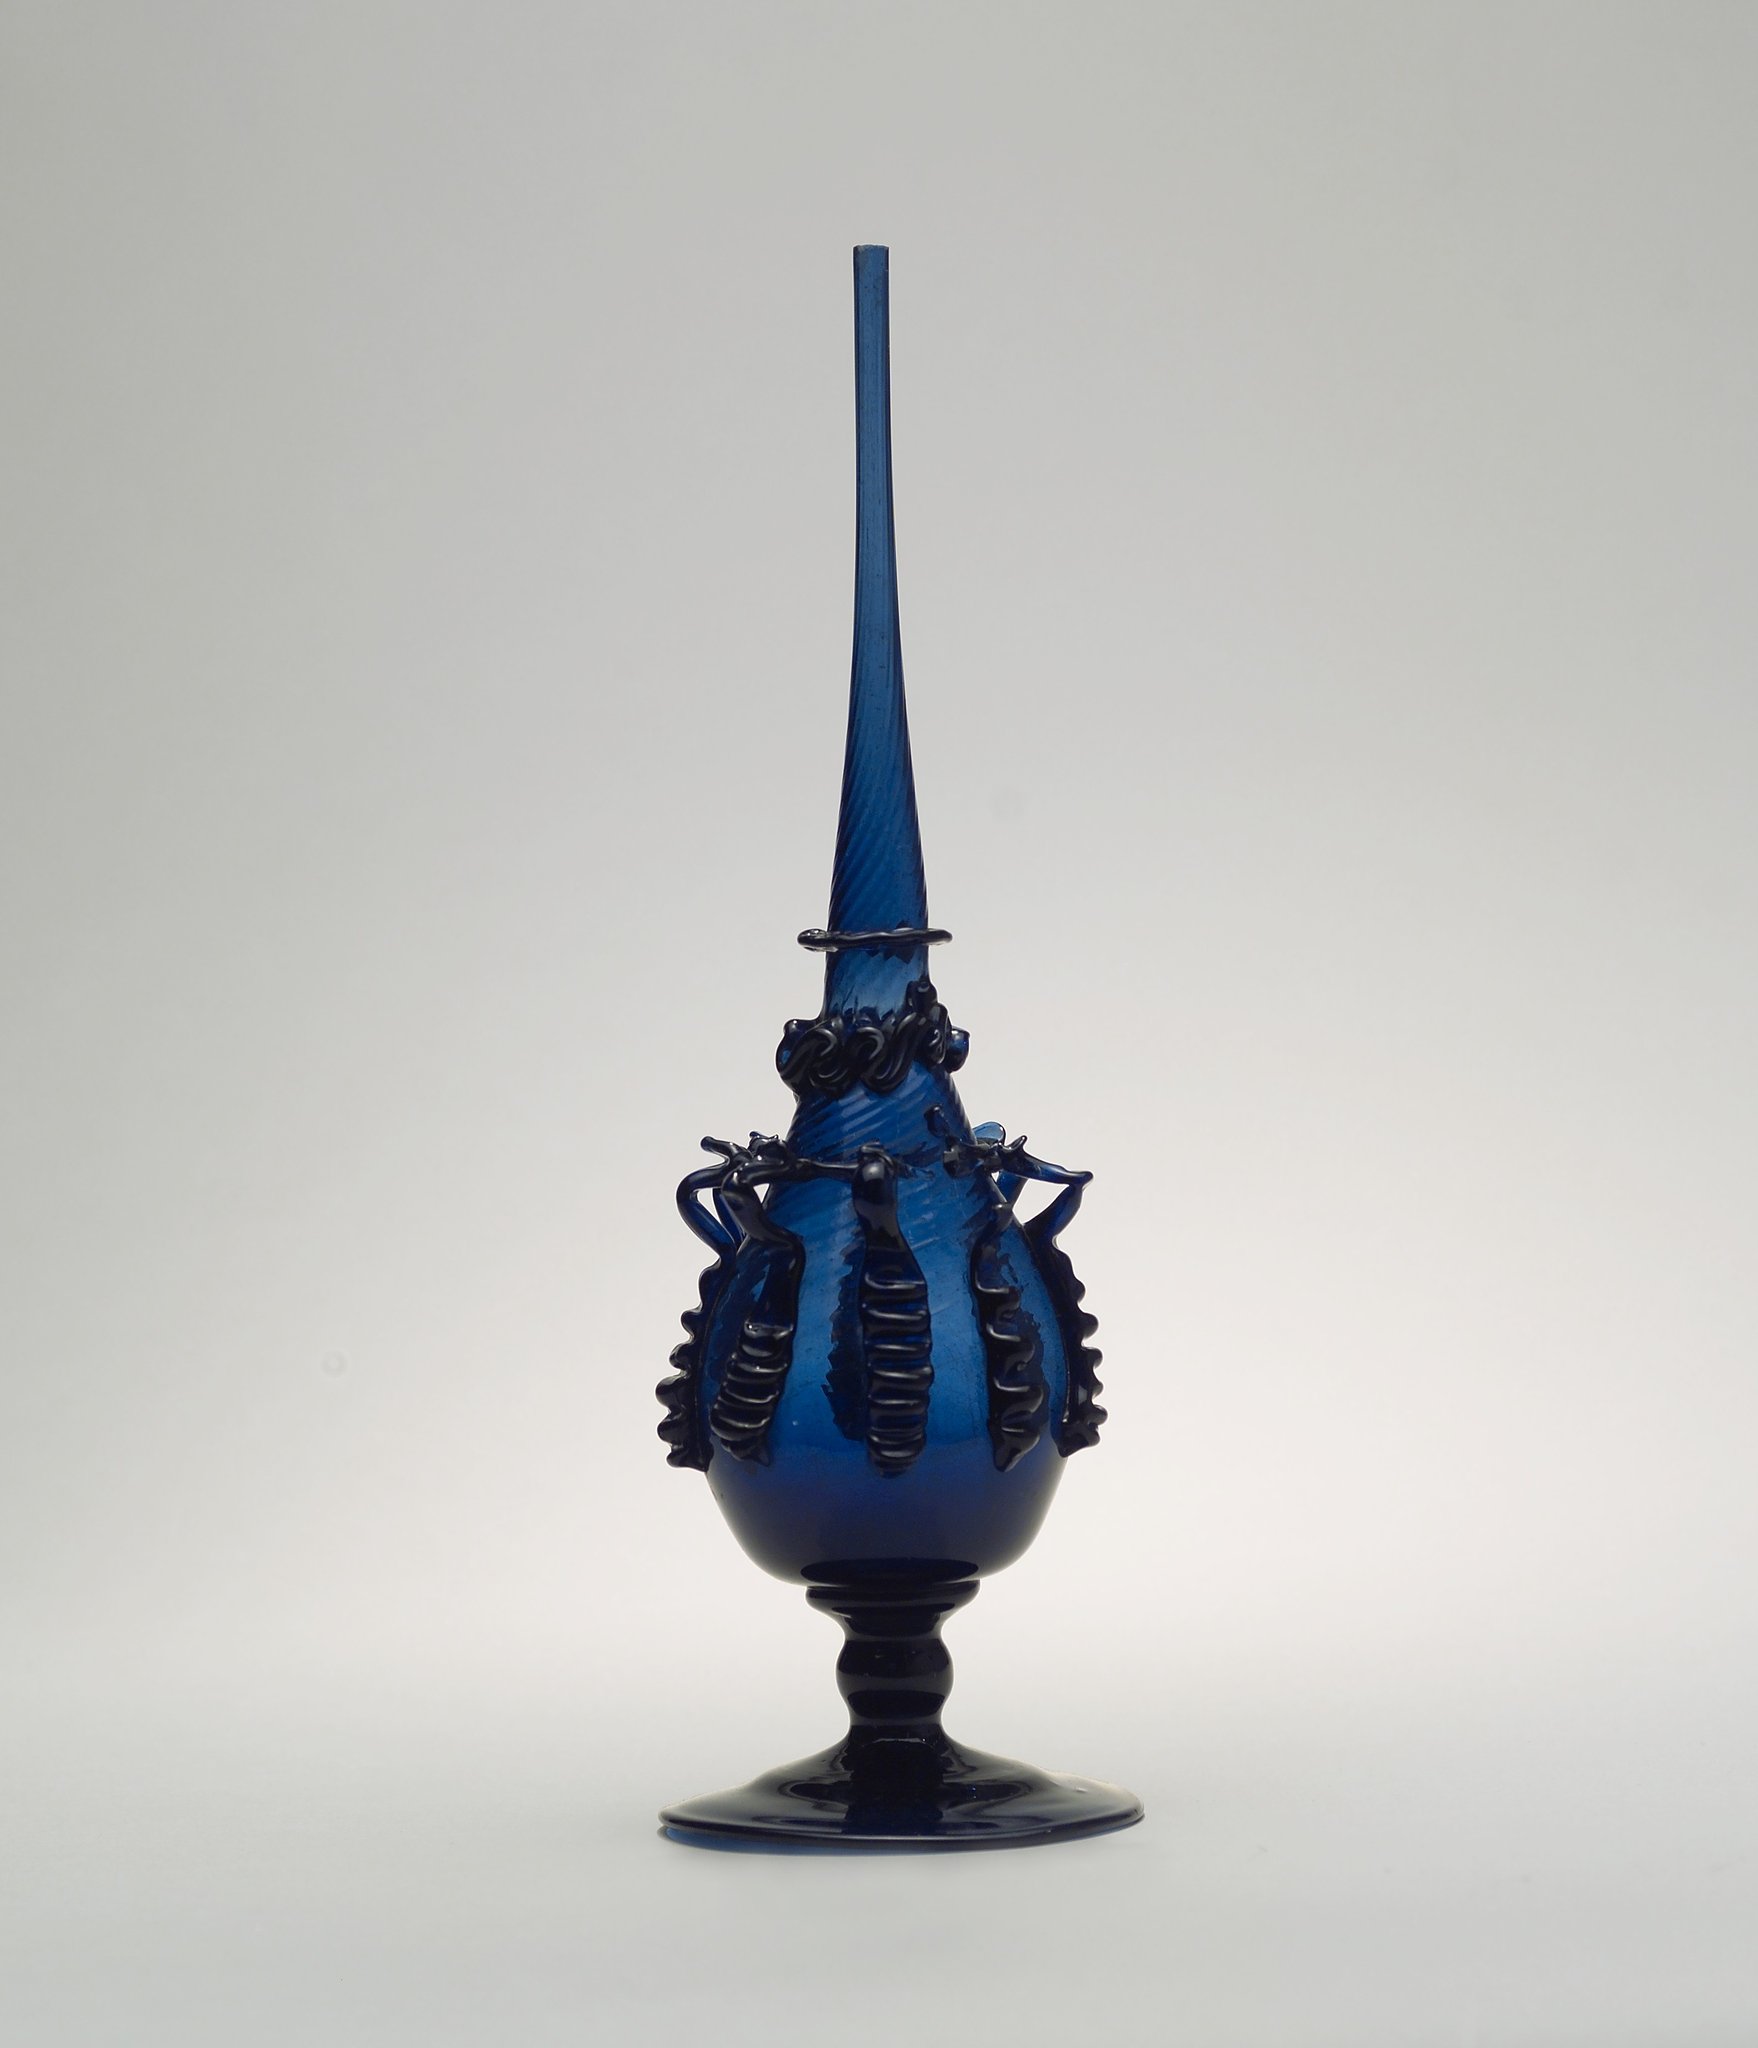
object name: sprinkler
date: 1801-1900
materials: glass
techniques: glassblowing, molding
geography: iran